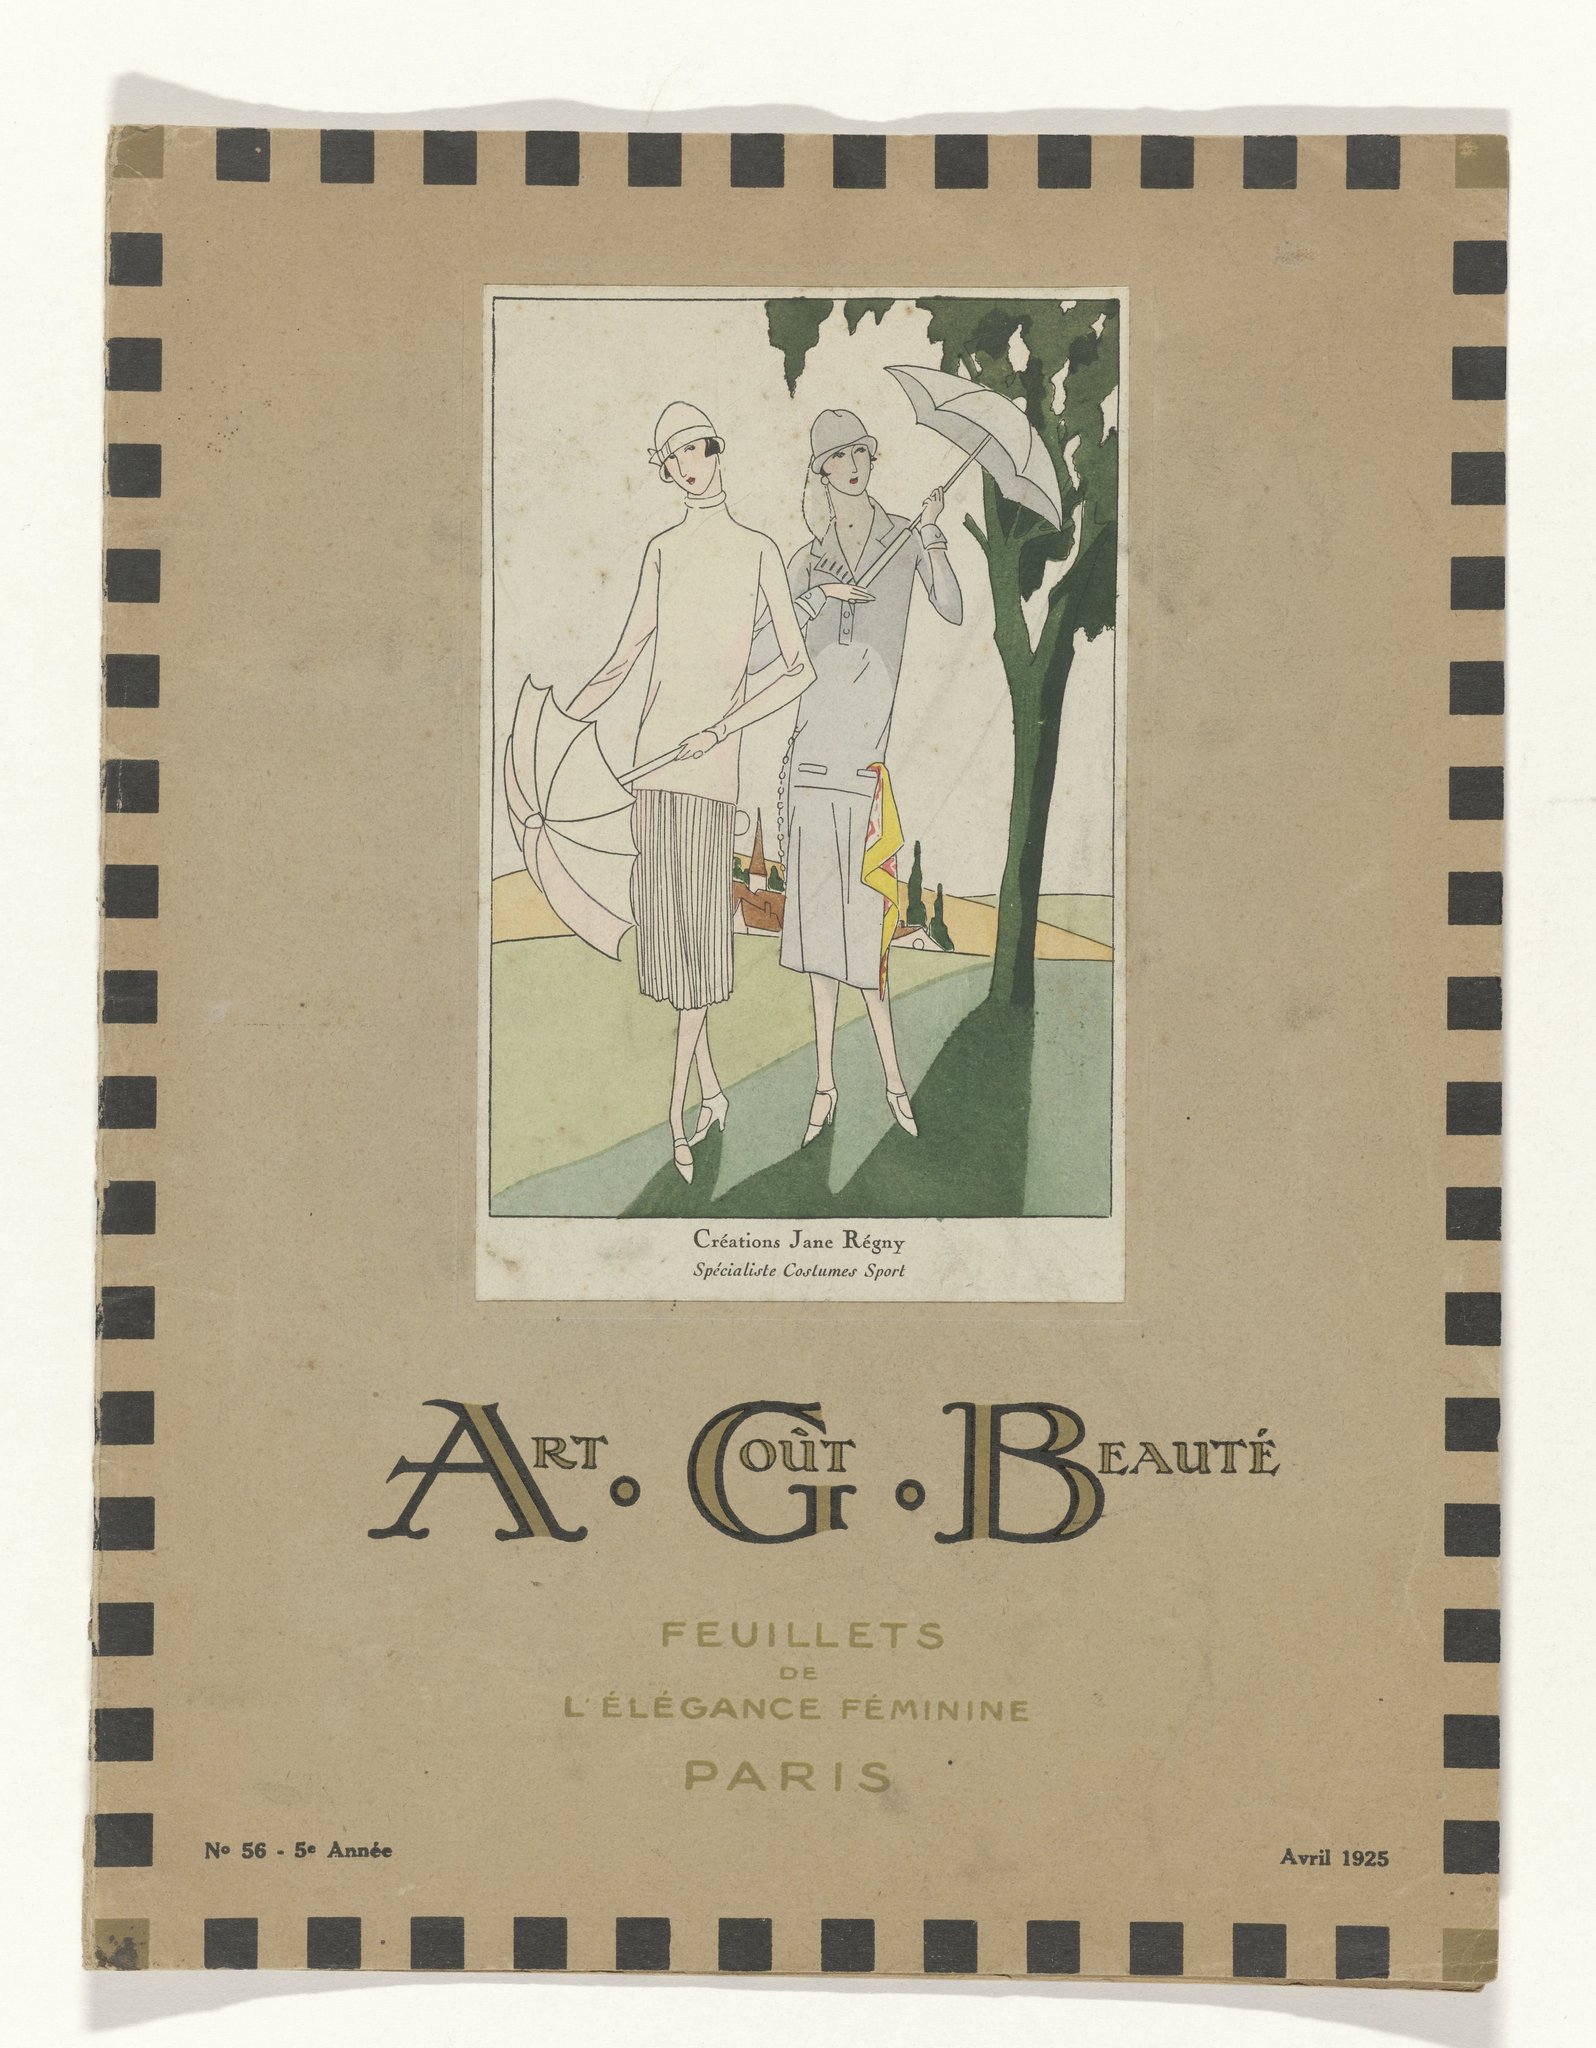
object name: magazine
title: Art - Goût - Beauté, Feuillets de l' élégance féminine, Avril 1925, No. 56, 5e Année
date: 1925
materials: paper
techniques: brush, hand coloring, lithograph, pochoir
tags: fashion plates, dress, gown (+ women's clothes), parasol, sunshade (+ women's clothes)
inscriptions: title: ‘ART. GOÛT. BEAUTÉ’, title: ‘FEUILLETS DE L'ÉlÉGANCE FÉMININE / PARIS’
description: Omslag van het modetijdschrift Art-Goût-Beauté (1920-1933), april 1925, No. 56. Afbeelding van twee vrouwen met parasols, gekleed in ensembles van Jane Régny, 'Spécialiste Costumes Sport'.